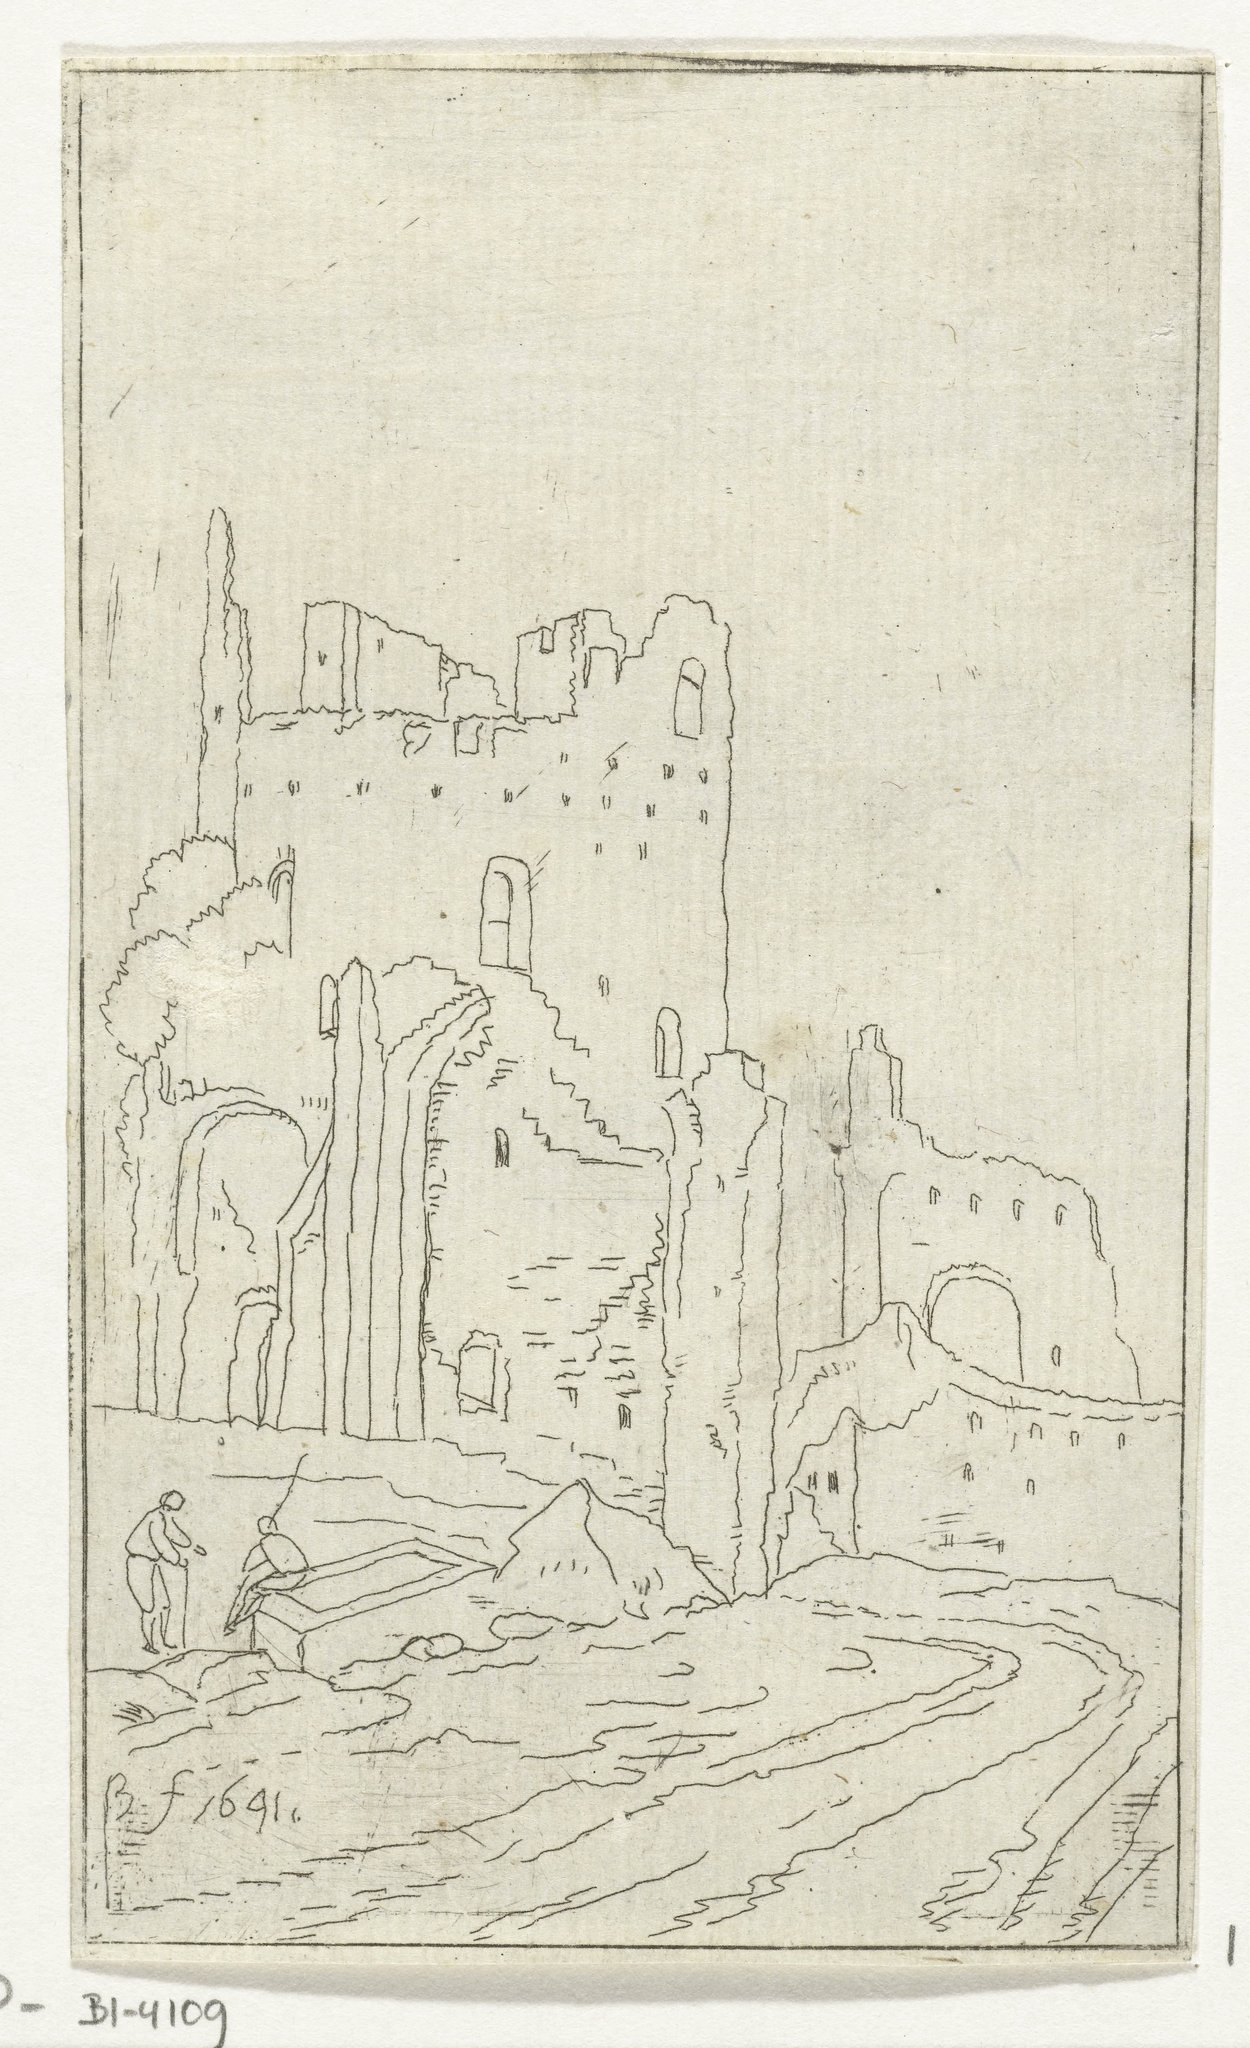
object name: print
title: Ruïne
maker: anthonie van den bos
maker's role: draughtsman, print maker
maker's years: 1763-1838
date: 1778-1838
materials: paper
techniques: etching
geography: netherlands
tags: ruin of a dwelling, house, castle, etc.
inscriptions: collector's mark: Lugt 2228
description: Ruïne van een burcht, op de voorgrond twee figuren bij een waterbassin.